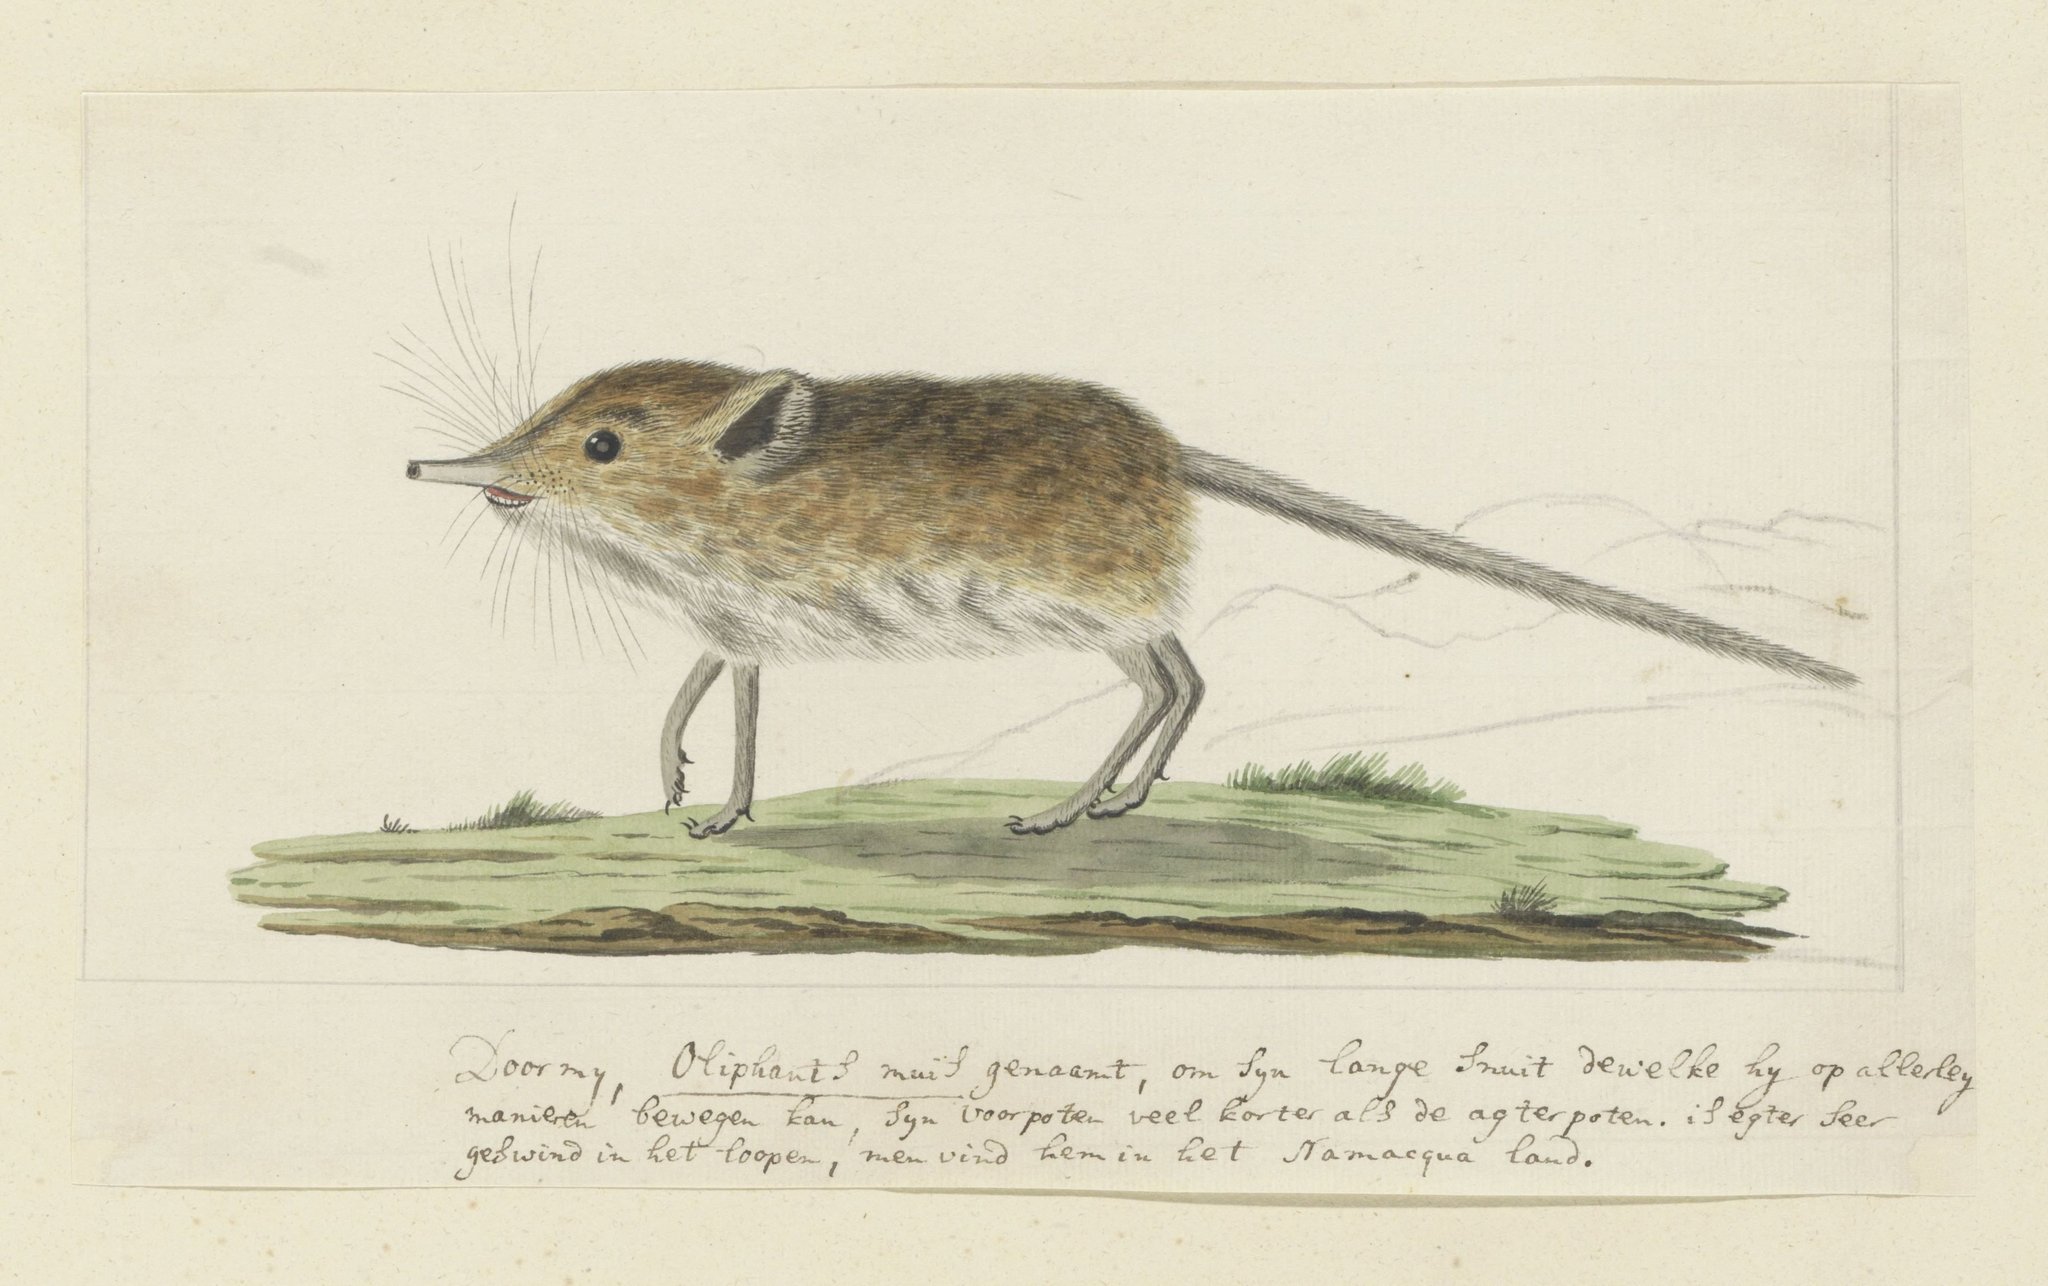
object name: drawing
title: Macroscelides proboscideus (Round-eared elephant shrew)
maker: robert jacob gordon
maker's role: draughtsman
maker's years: 1743-1795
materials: chalk, ink, paper, pencil, watercolor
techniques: brush, pen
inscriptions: annotation: ‘Door mij, Oliphantsmuis [onderstreept] genaamt, [...]’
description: Determinatie gebaseerd op de korte oren.